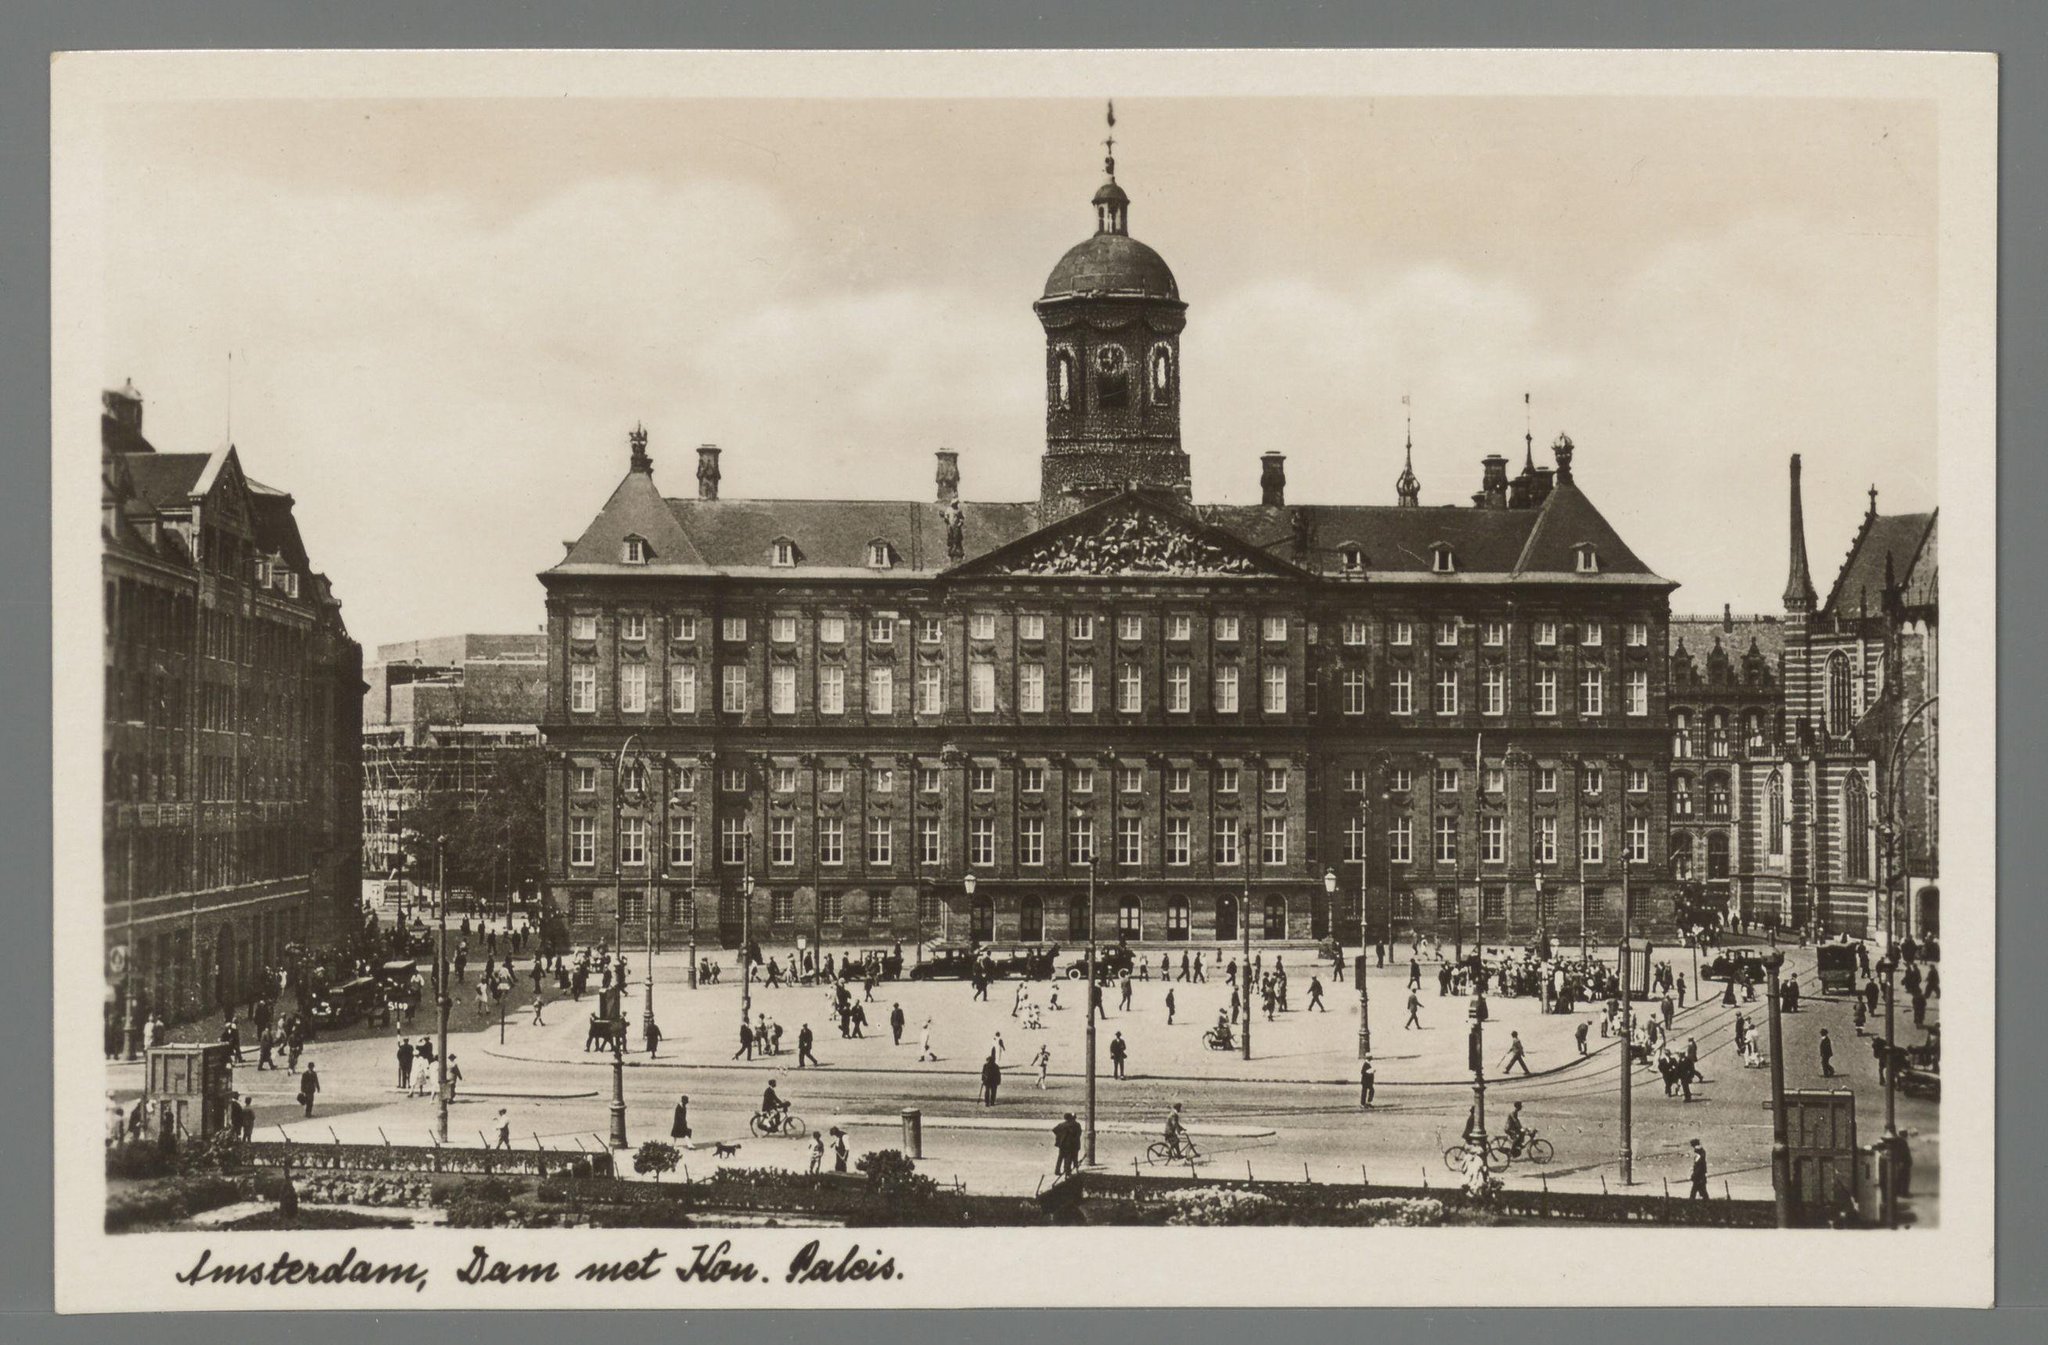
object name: ansichtkaart, prentbriefkaart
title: Koninklijk Paleis Amsterdam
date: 1932-1947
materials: photographic support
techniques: photography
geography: the hague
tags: palace, square, place, circus, etc. (+ city(-scape) with figures, staffage), royal palace of amsterdam